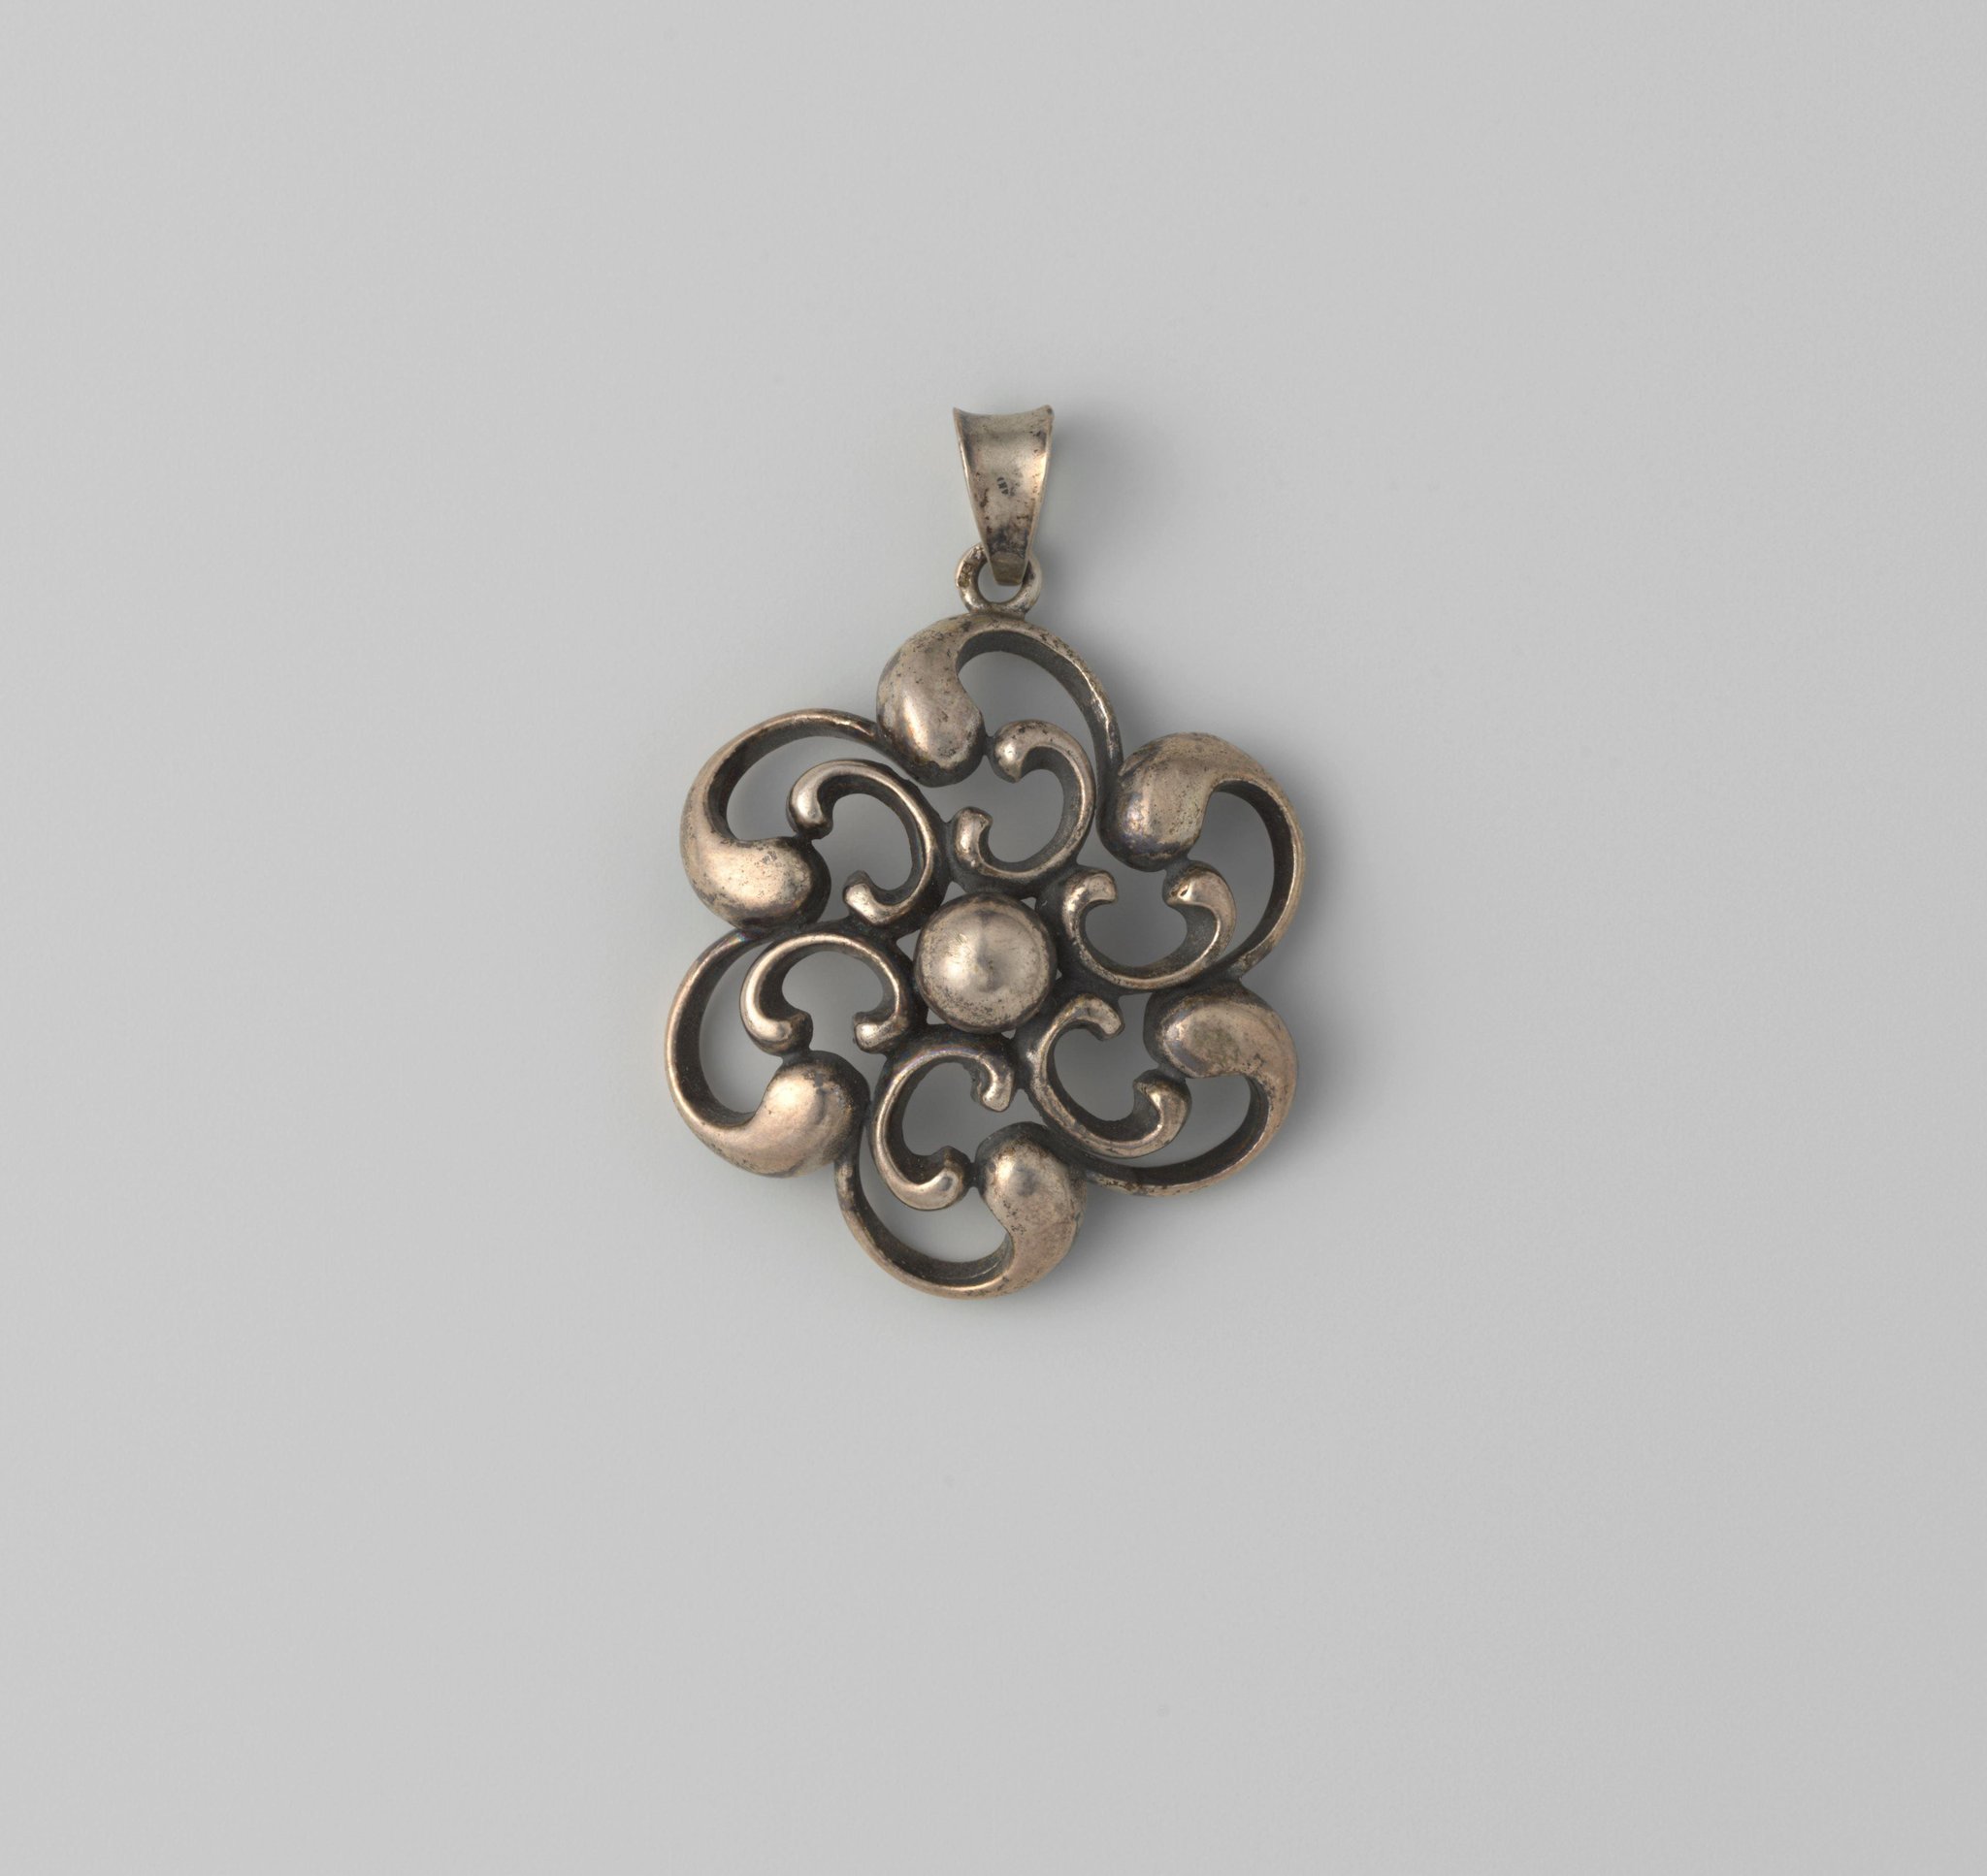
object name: pendant jewelry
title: Ronde hanger van zilver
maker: Anonymous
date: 1970-1980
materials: silver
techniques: casting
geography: netherlands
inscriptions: alloy mark: ‘zwaard 835’, maker's mark: ‘N10’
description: Ronde hanger van zilver voorzien van een plaatoog. De hanger is in de vorm van een ajour bloem met een bol in het midden.